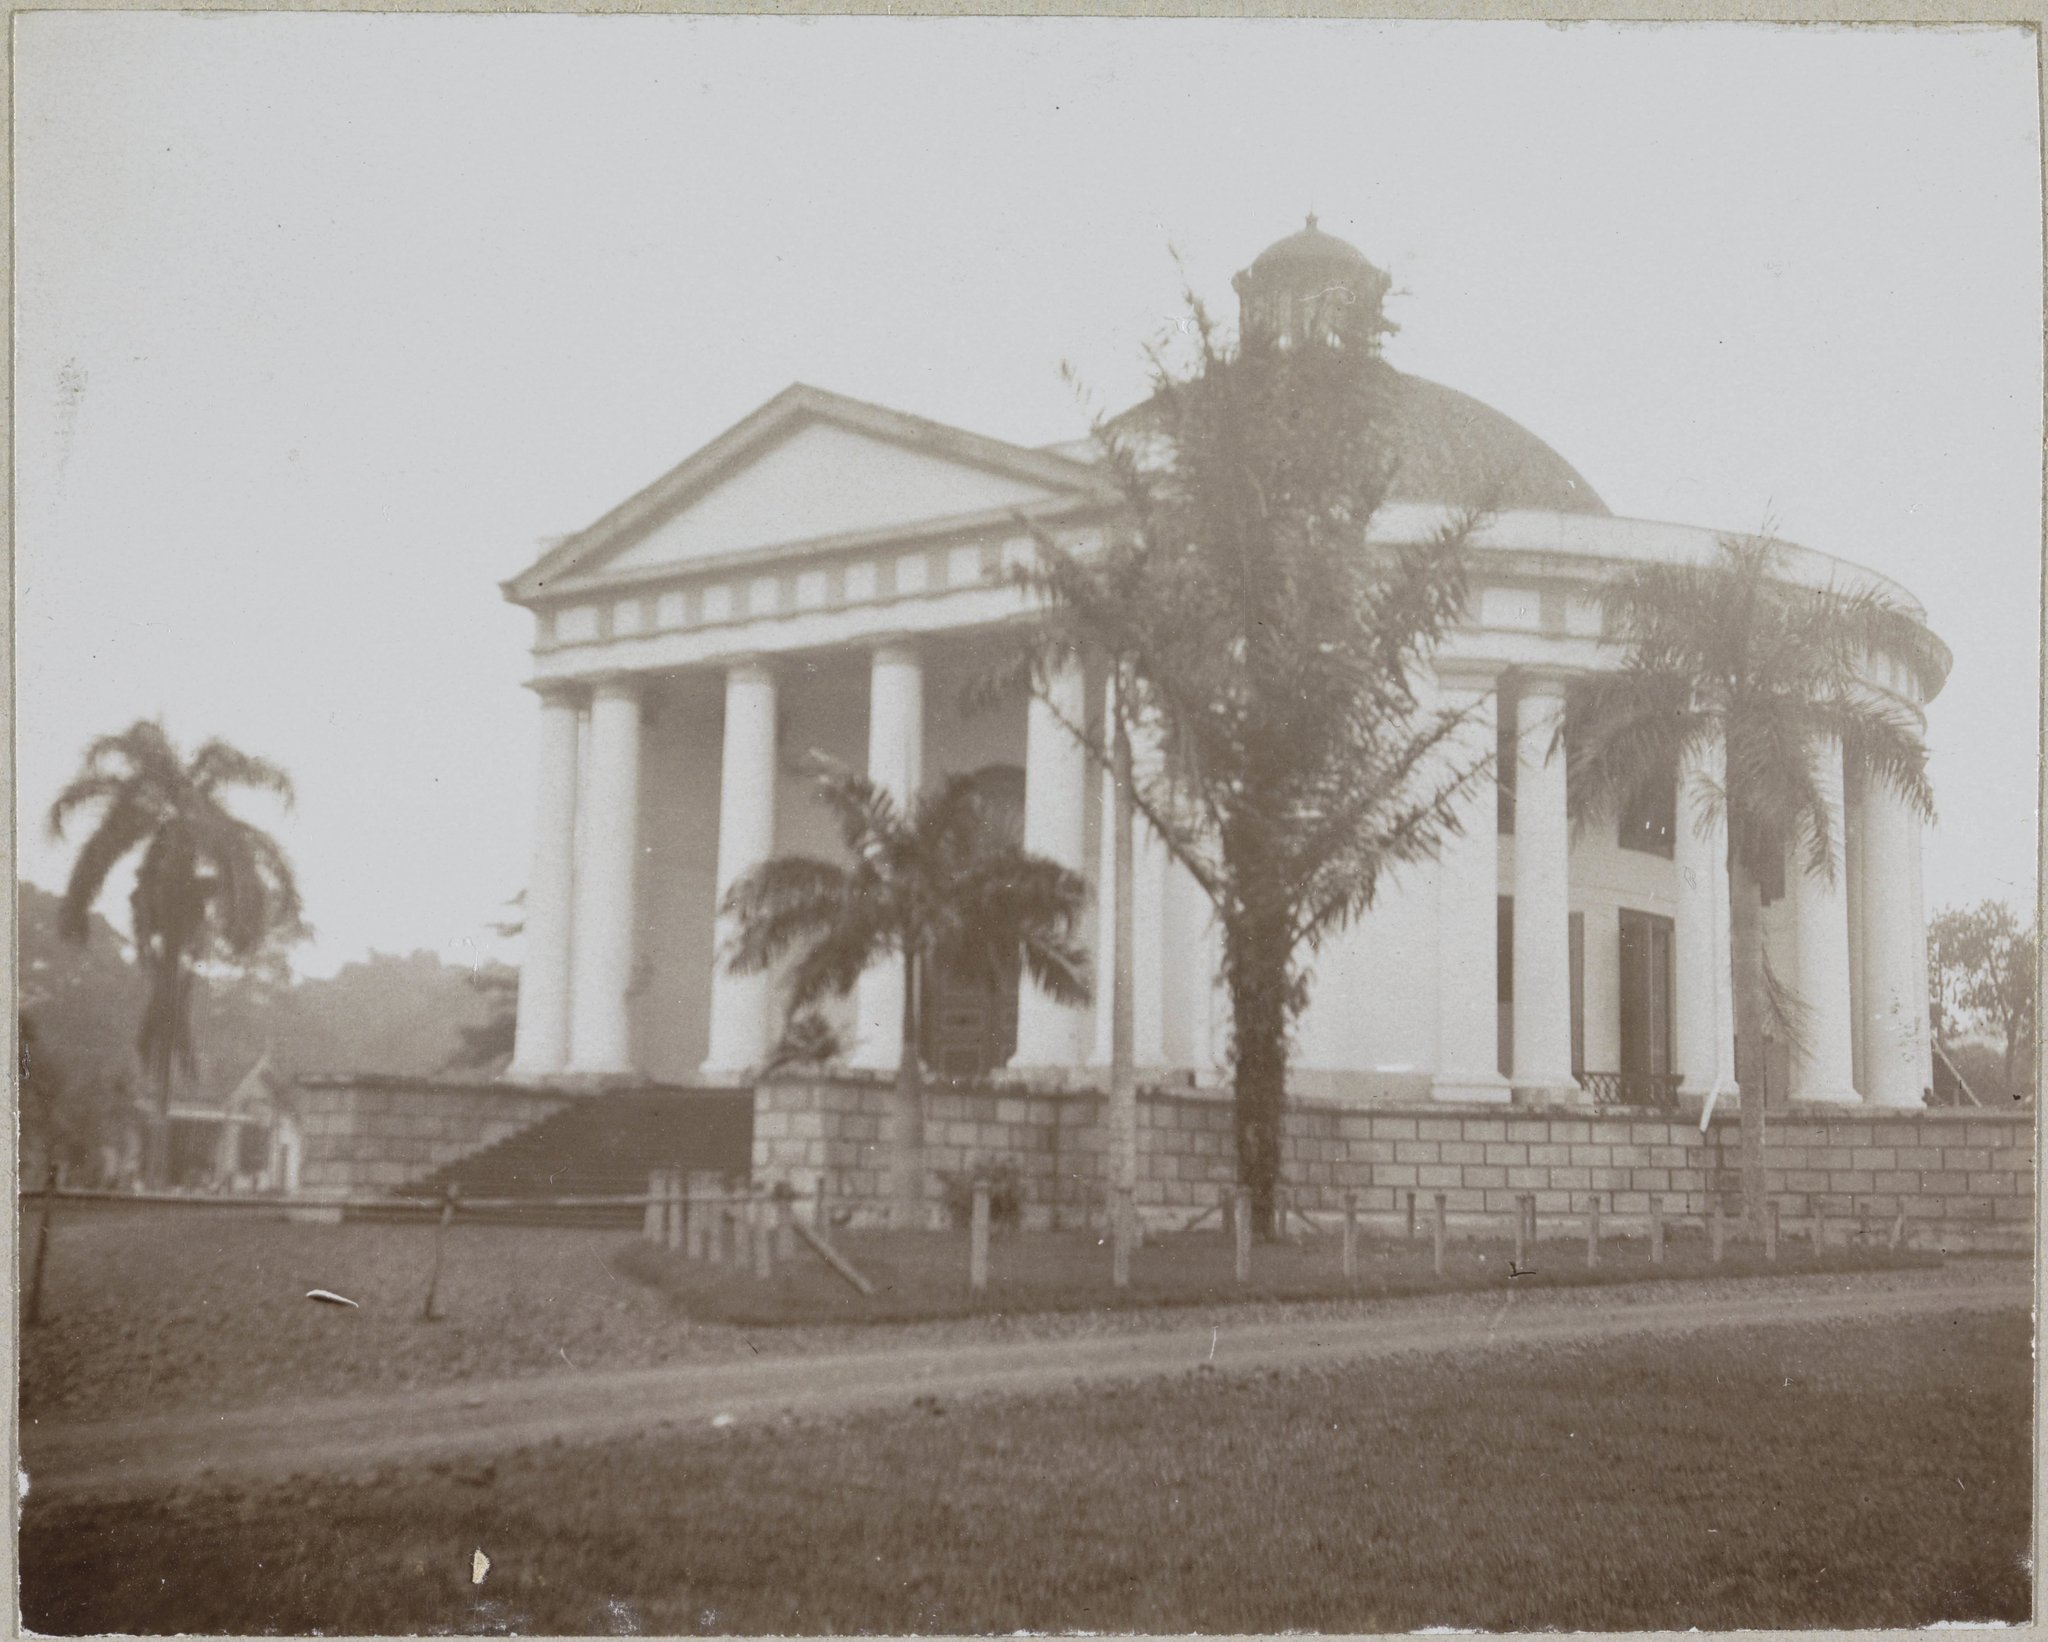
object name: photograph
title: Willemskerk, Batavia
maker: Anonymous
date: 1895-1915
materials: cardboard, paper, photographic support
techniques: collodion silver print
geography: batavia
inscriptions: annotation: ‘2) Willemskerk te Batavia’